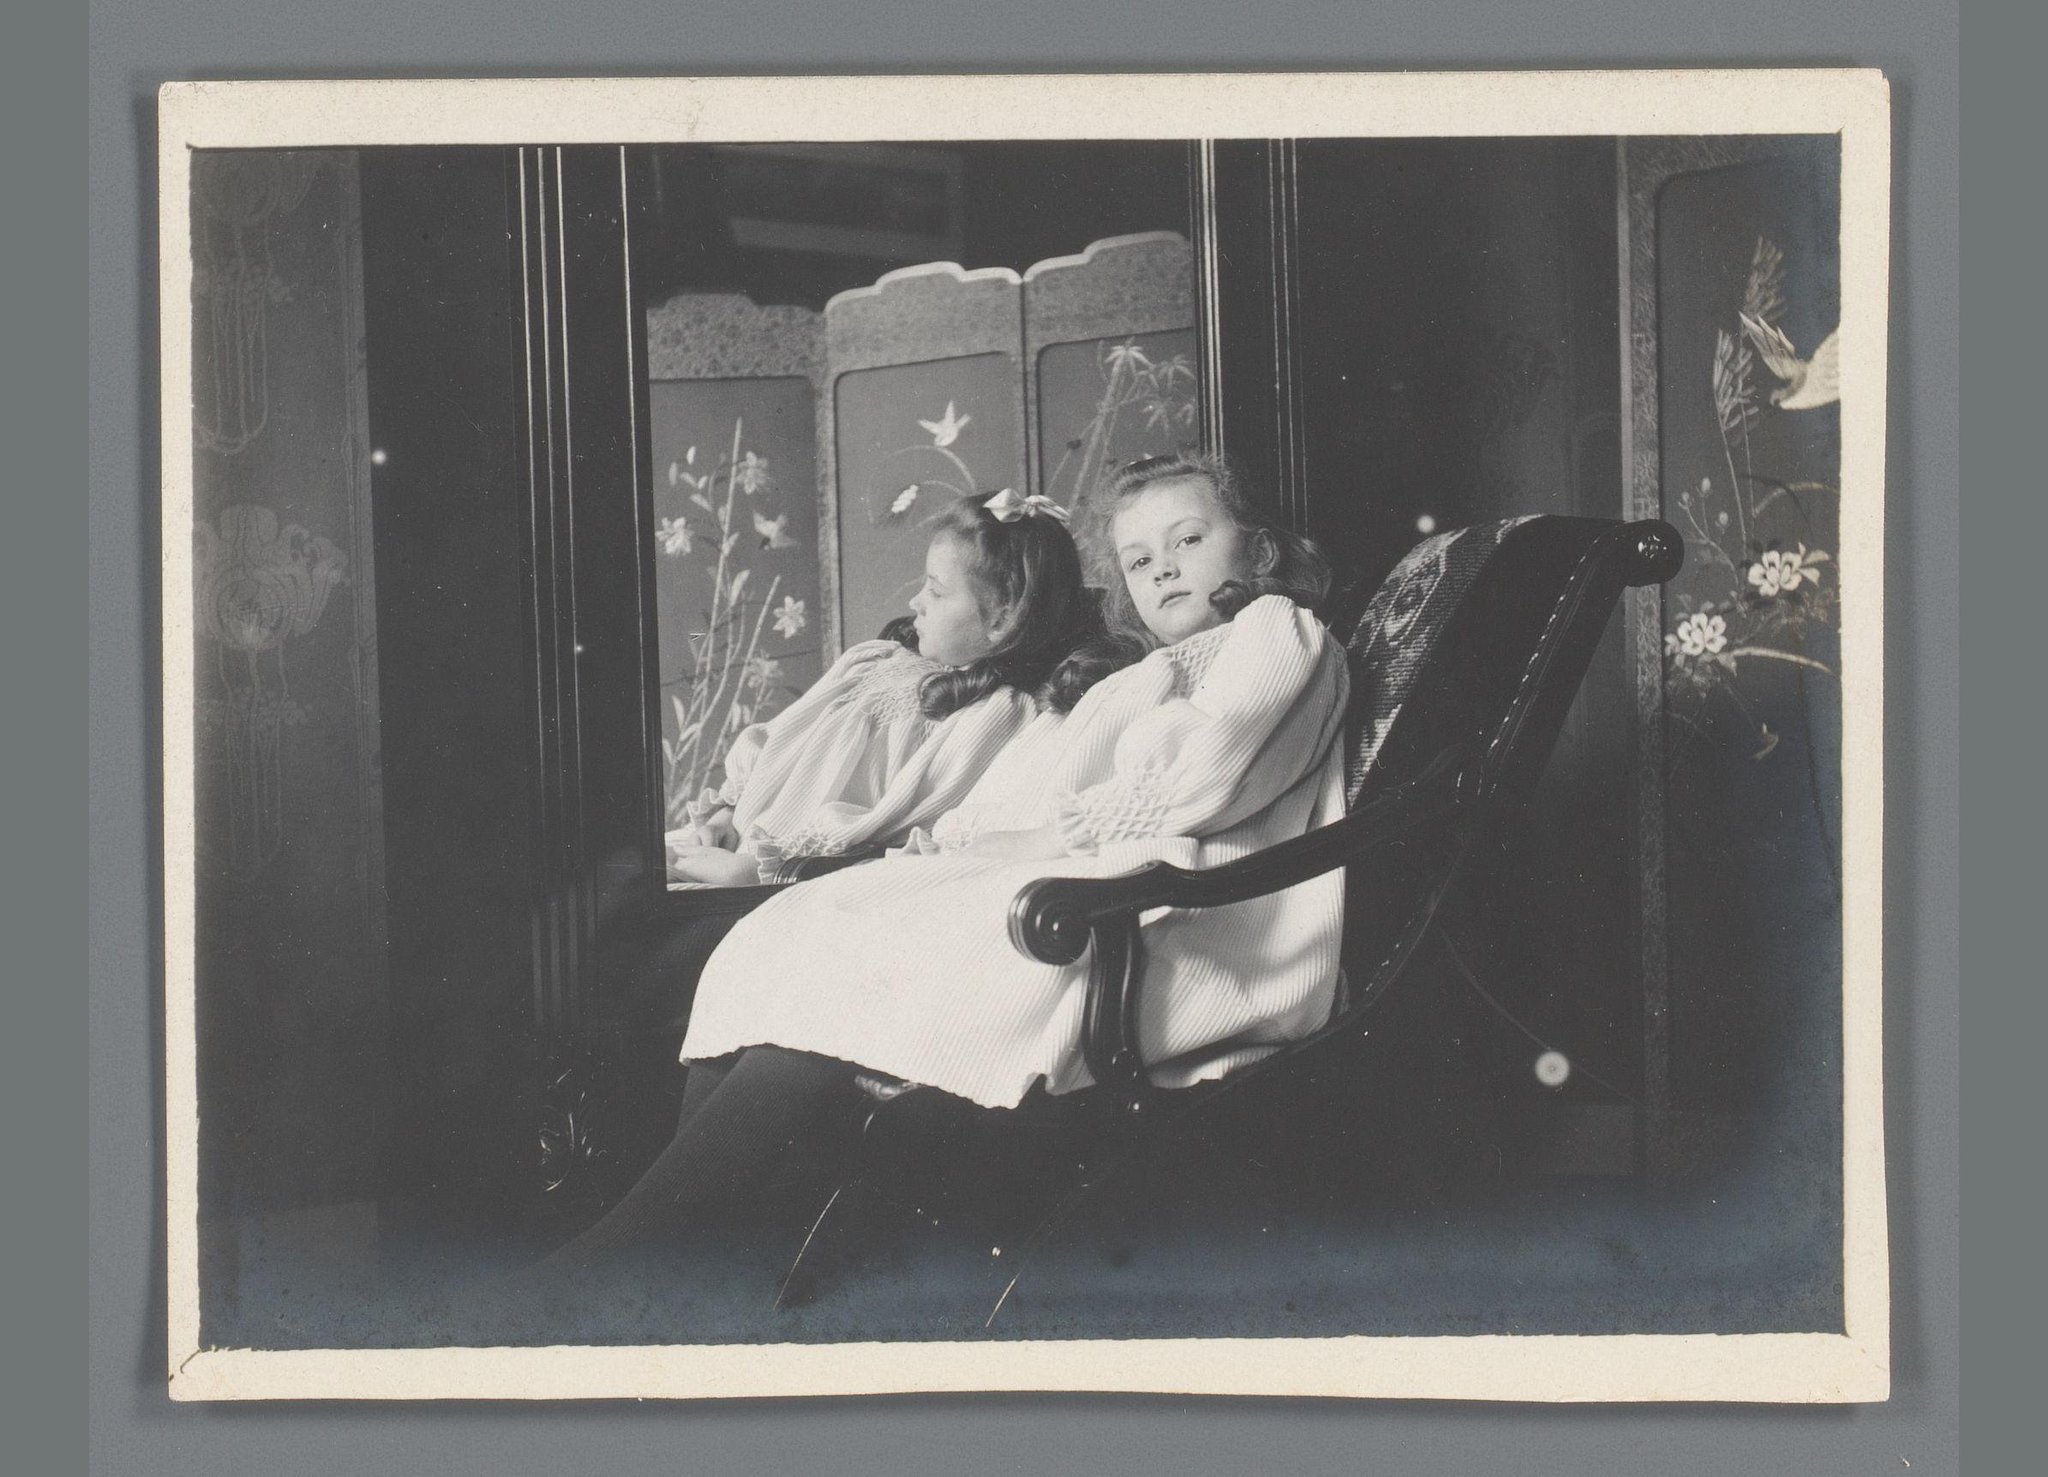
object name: photograph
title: Portret van Johanna (Hans) de Jong zittend voor een spiegel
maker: willem de jong (fotograaf)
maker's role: arts, fotograaf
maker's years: 1864-1918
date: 1900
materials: paper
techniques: gelatin silver print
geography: leiden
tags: johanna petronella lambertina stokhuyzen-de jong (hans), historical persons, girl (child between toddler and youth), reflection (in a mirror) - aa - (for) women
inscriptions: inscription: ‘H’